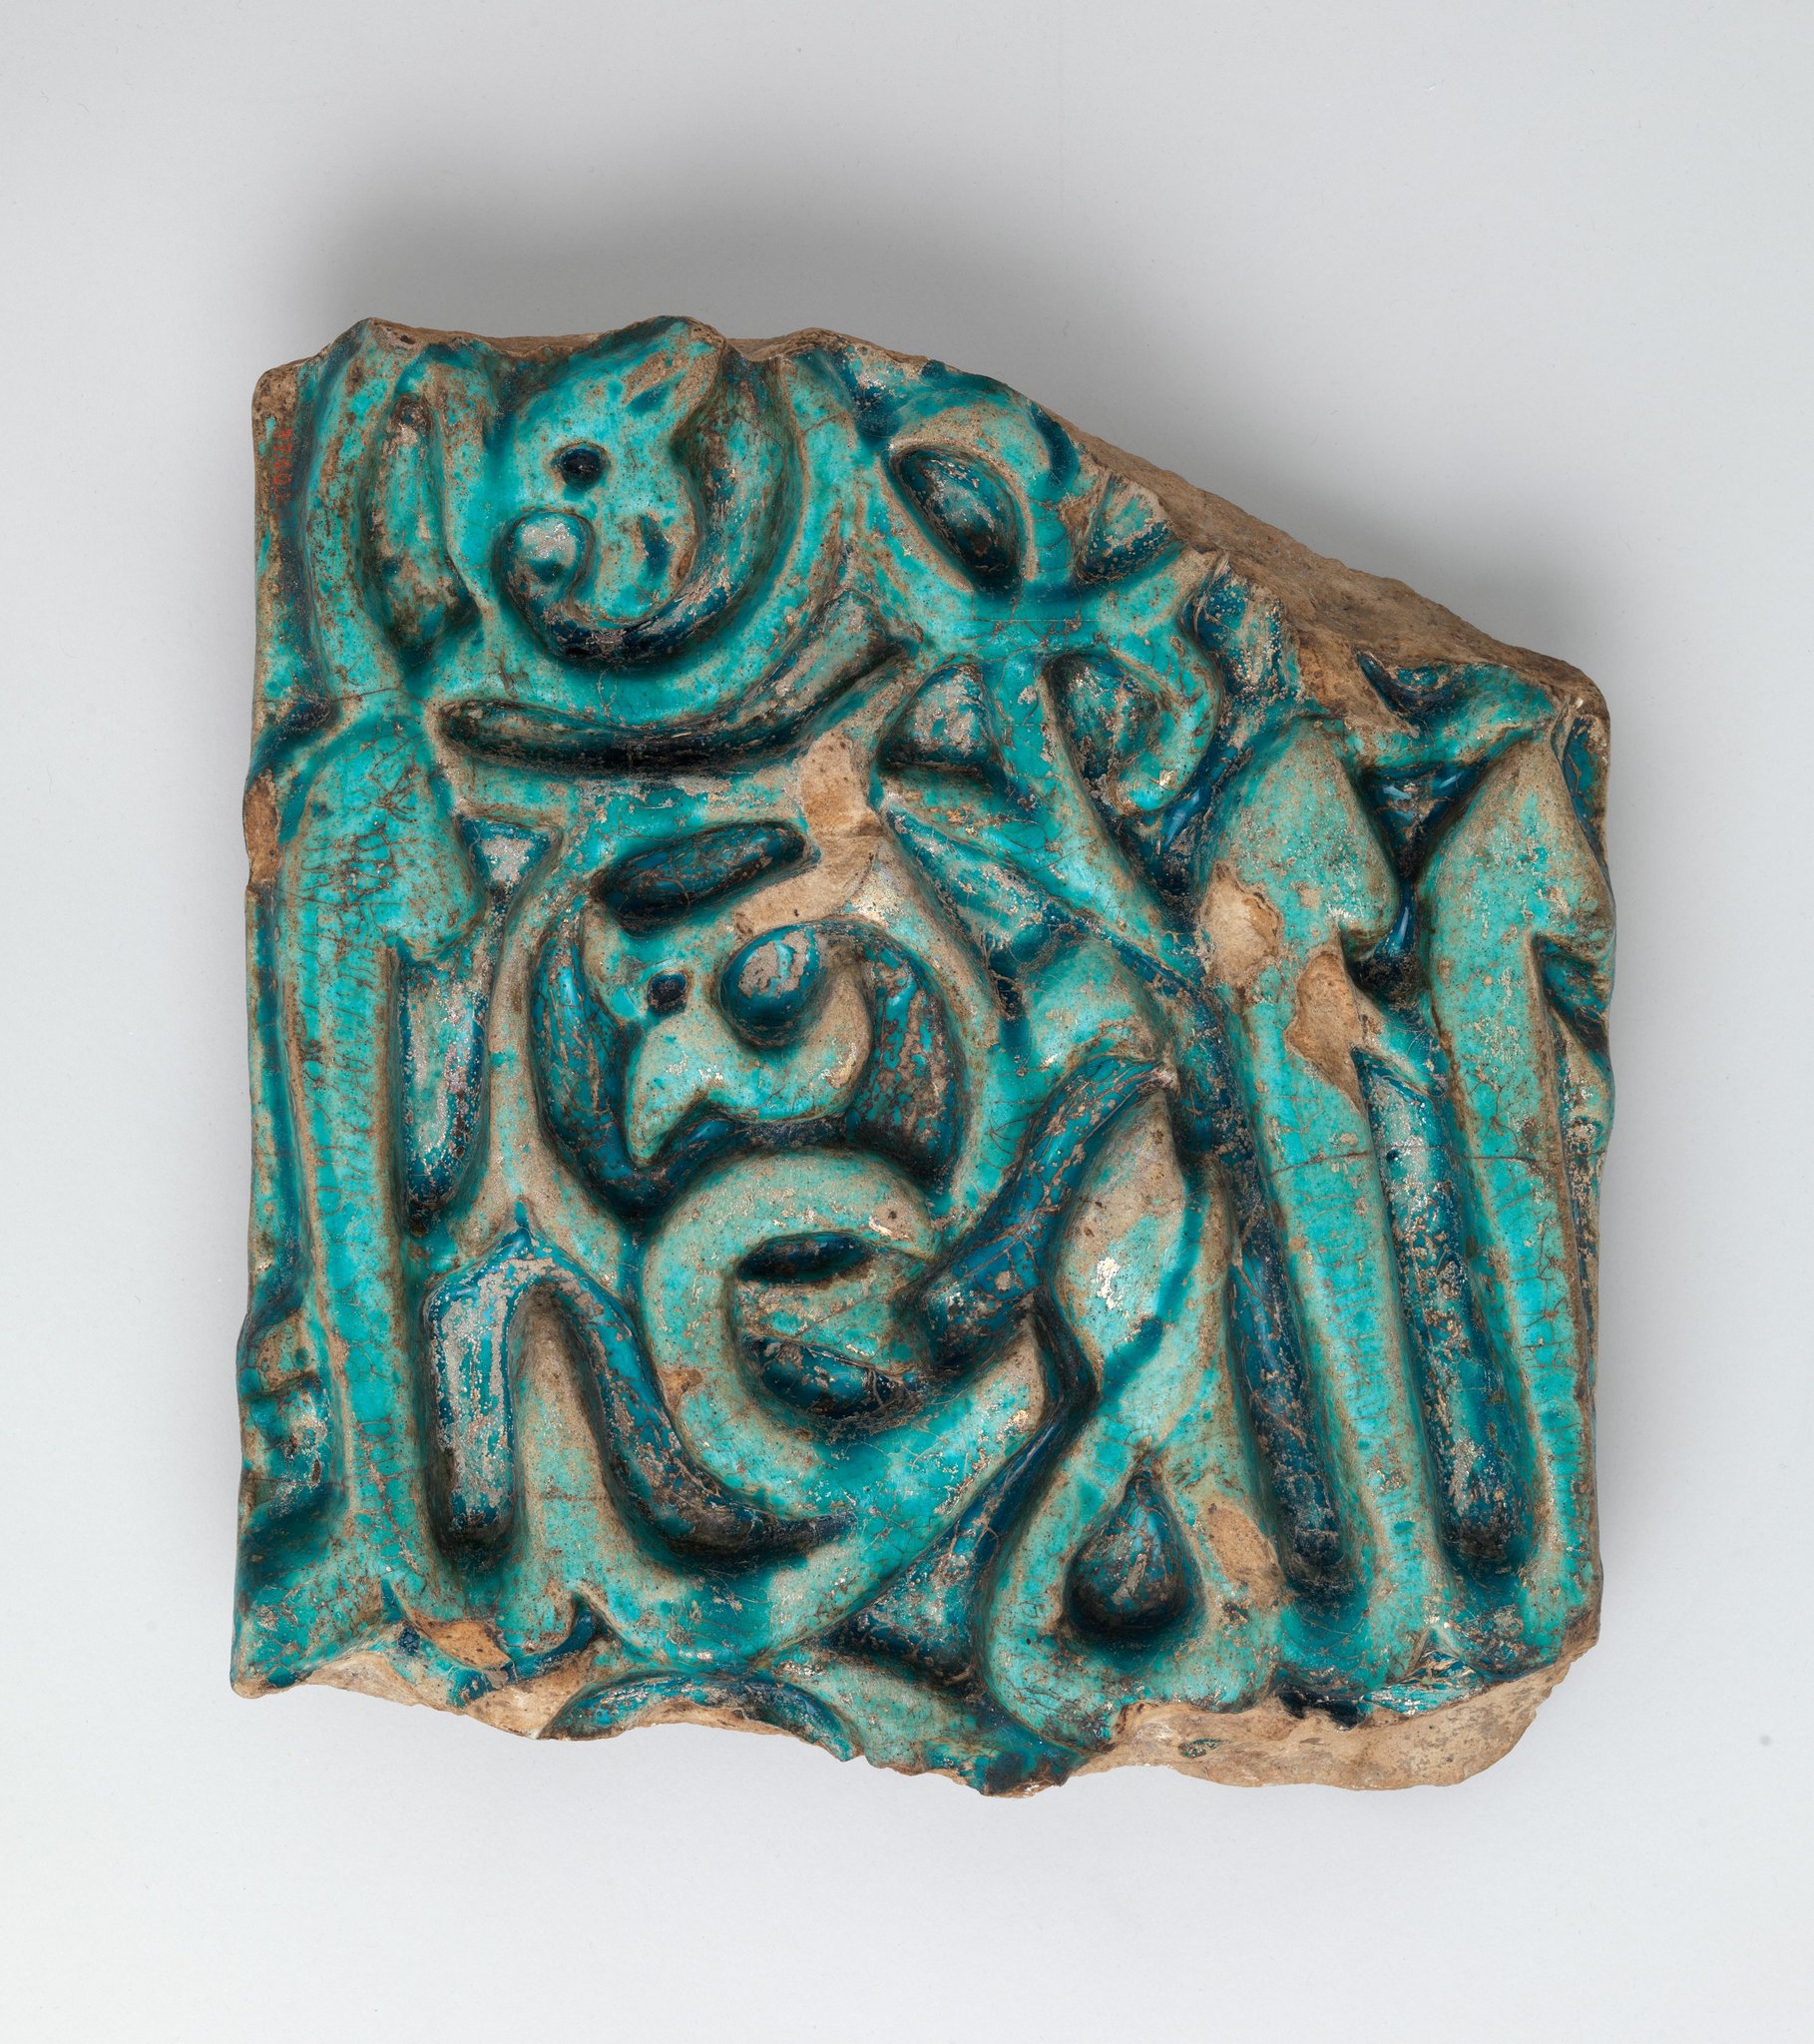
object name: tile fragment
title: Fragment of a Glazed Tile Inscription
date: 1101-1300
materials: glaze, stonepaste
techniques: carving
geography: iran